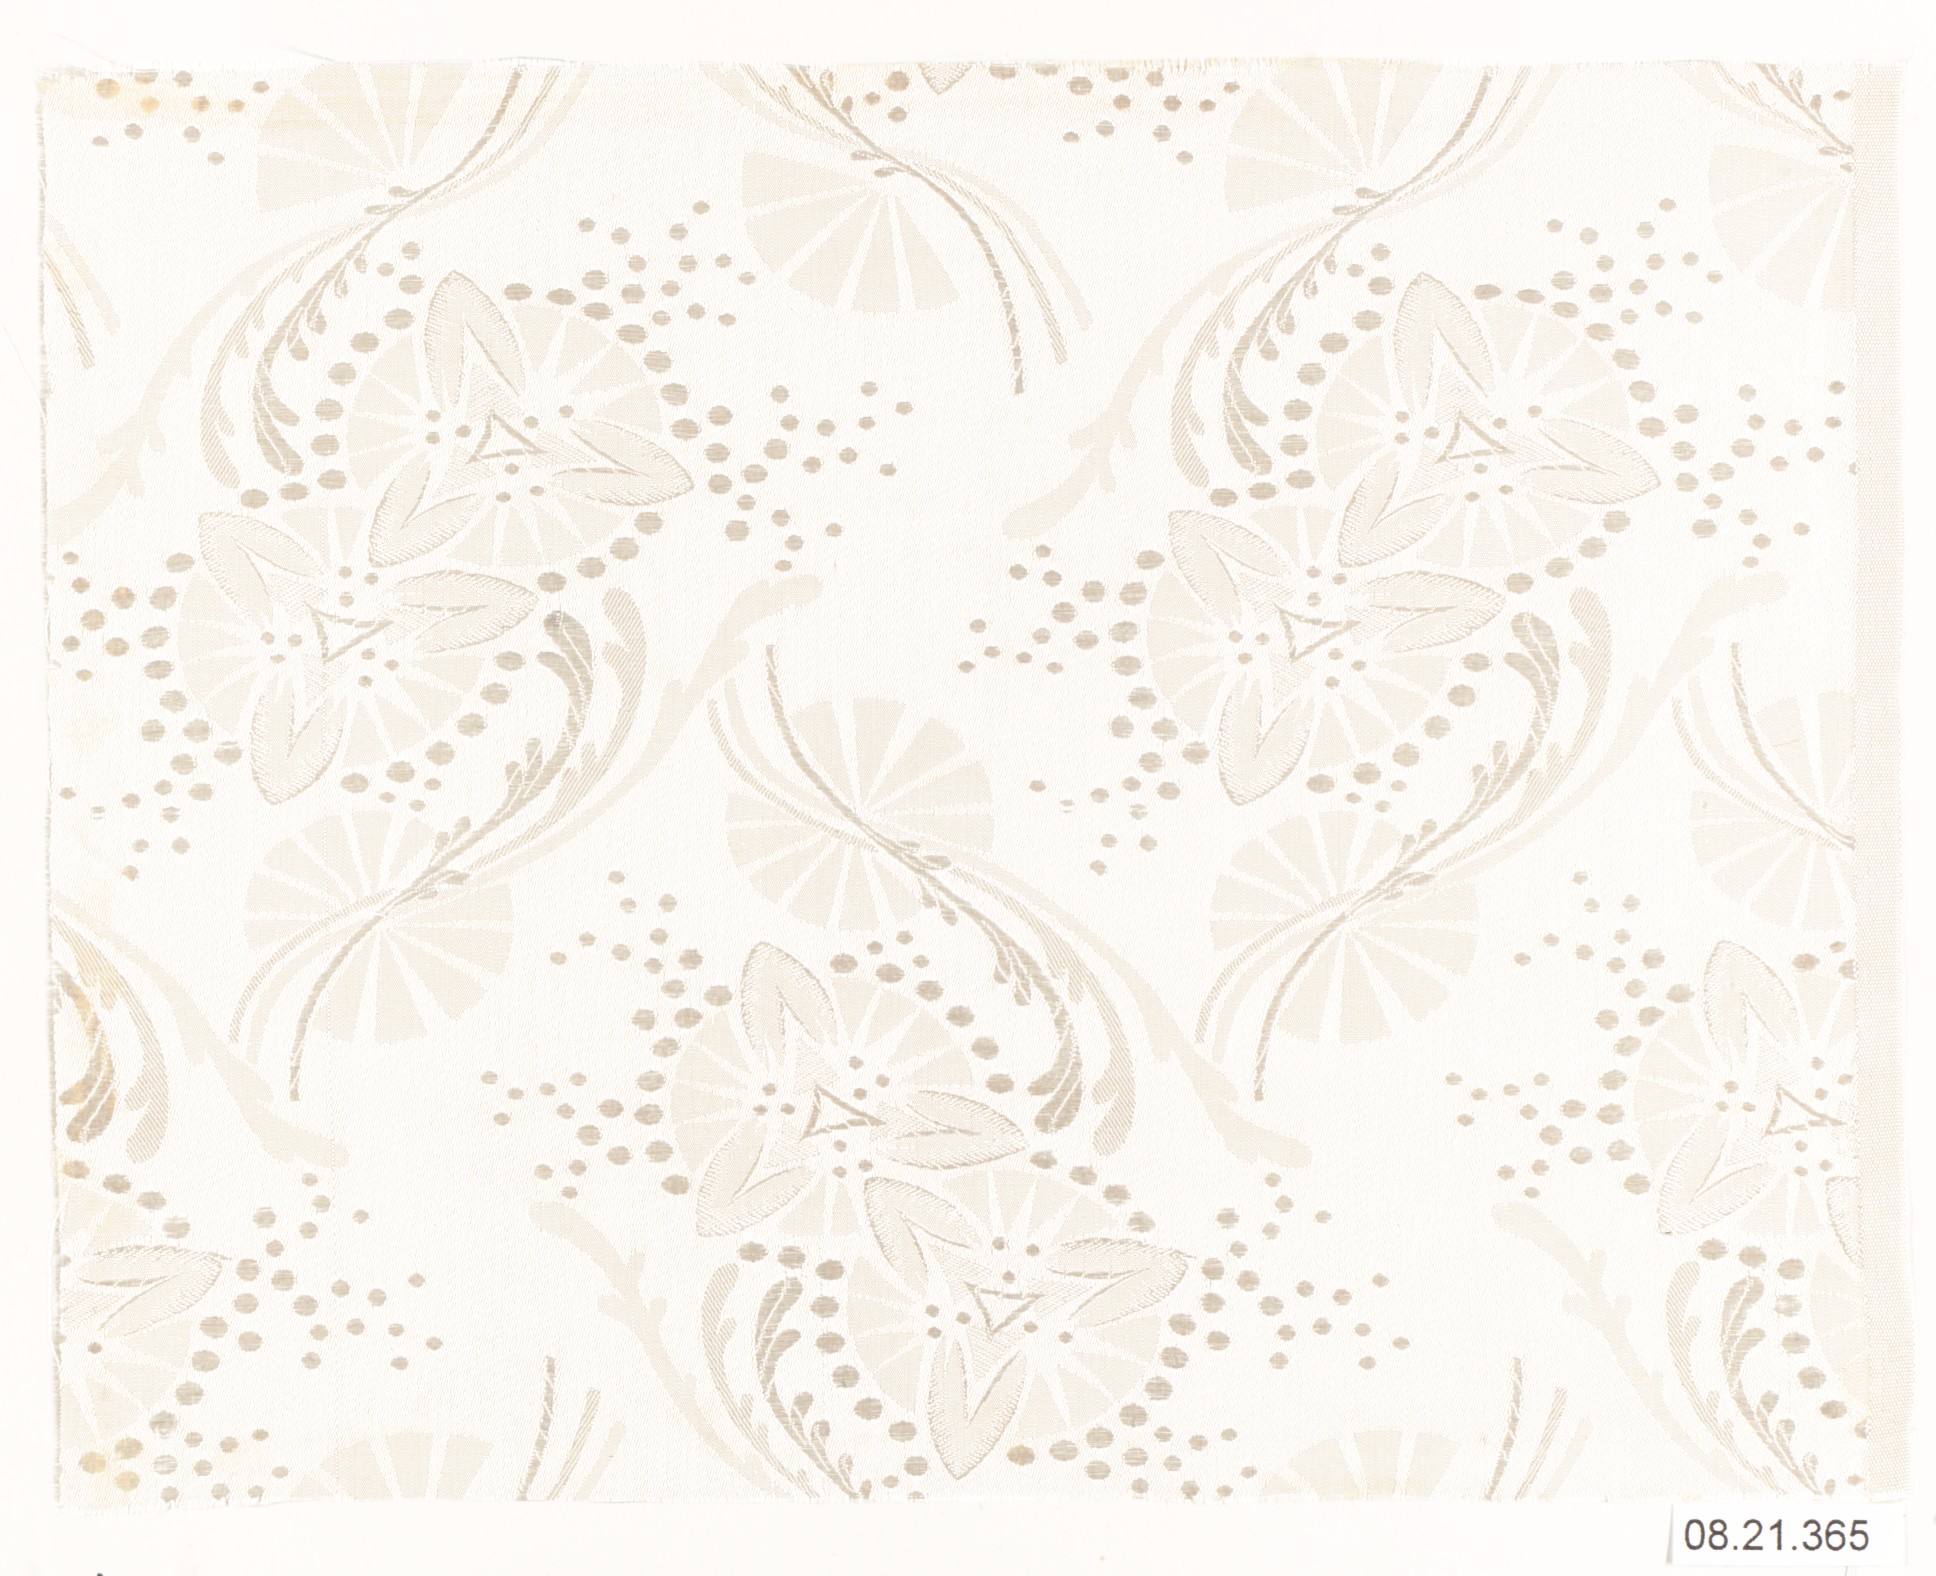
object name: textile sample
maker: Anonymous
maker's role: designer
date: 1900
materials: silk